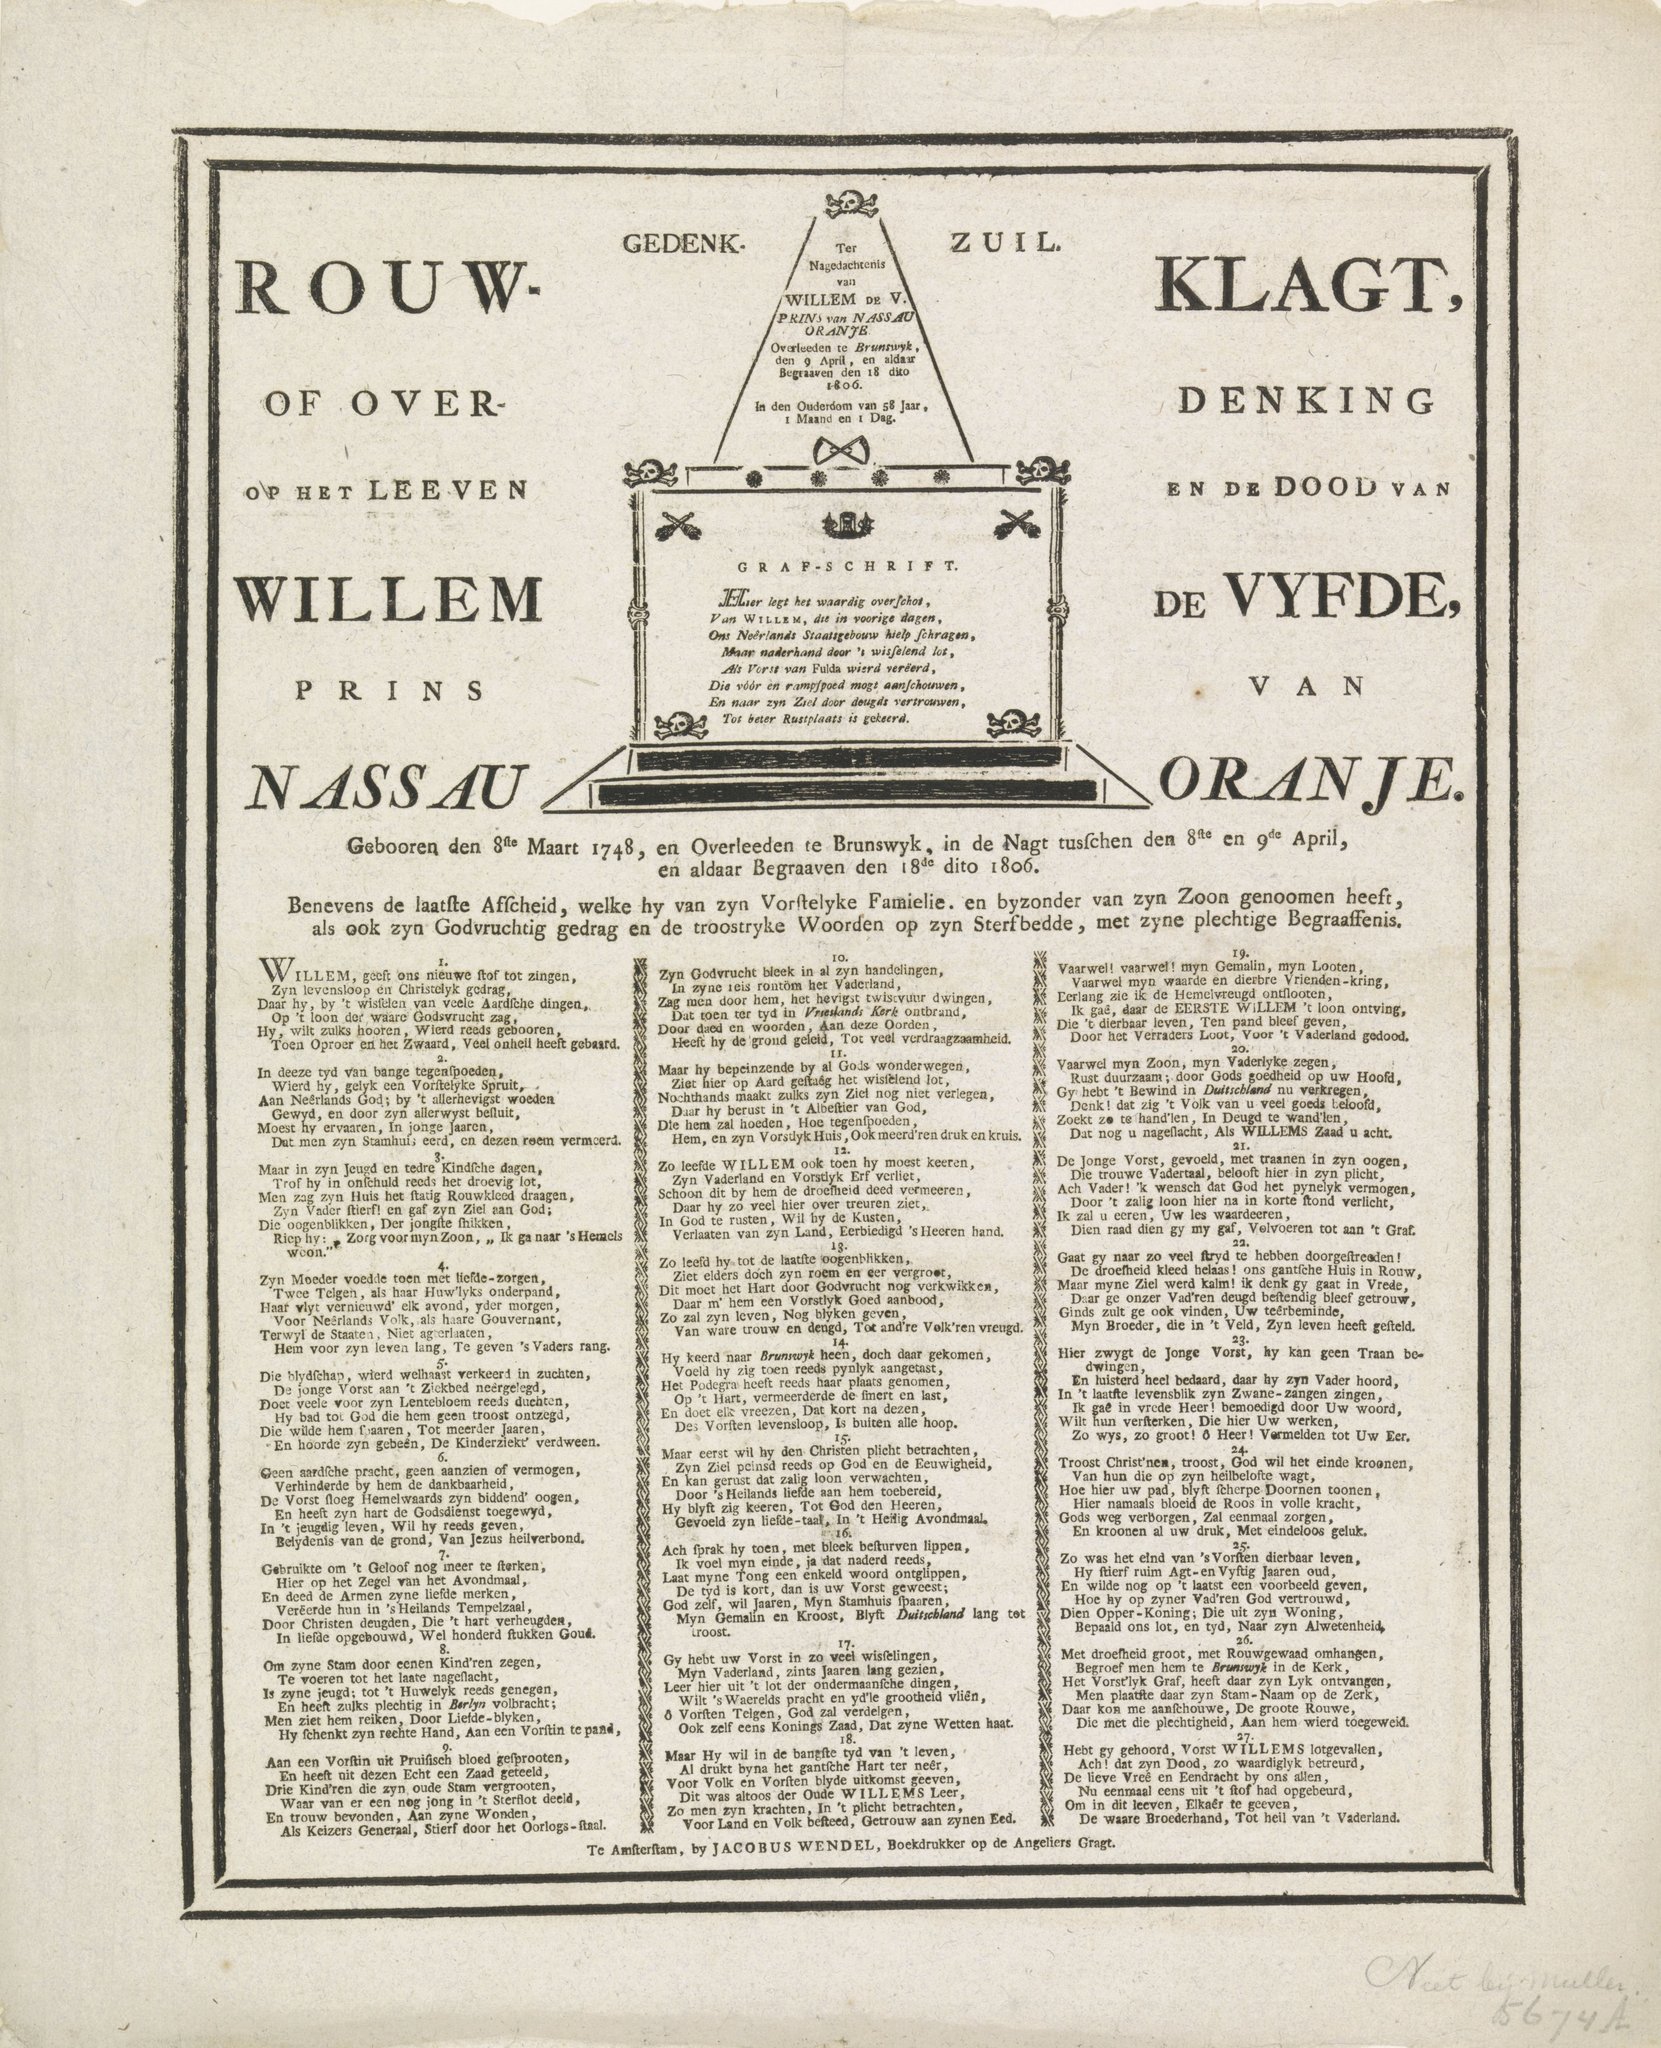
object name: print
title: Rouwklacht bij het overlijden van Willem V, 1806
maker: jacobus wendel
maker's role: printer, publisher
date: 1806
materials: paper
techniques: letterpress printing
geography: amsterdam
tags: the hague, william v (prince of orange)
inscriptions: collector's mark: Lugt 2228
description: Rouwklacht op het overlijden van prins Willem V op 9 april 1806. Middenboven een gedenkzuil met grafschrift. Rouwvers in 27 coupletten in drie kolommen. Binnen een dubbele rouwrand.